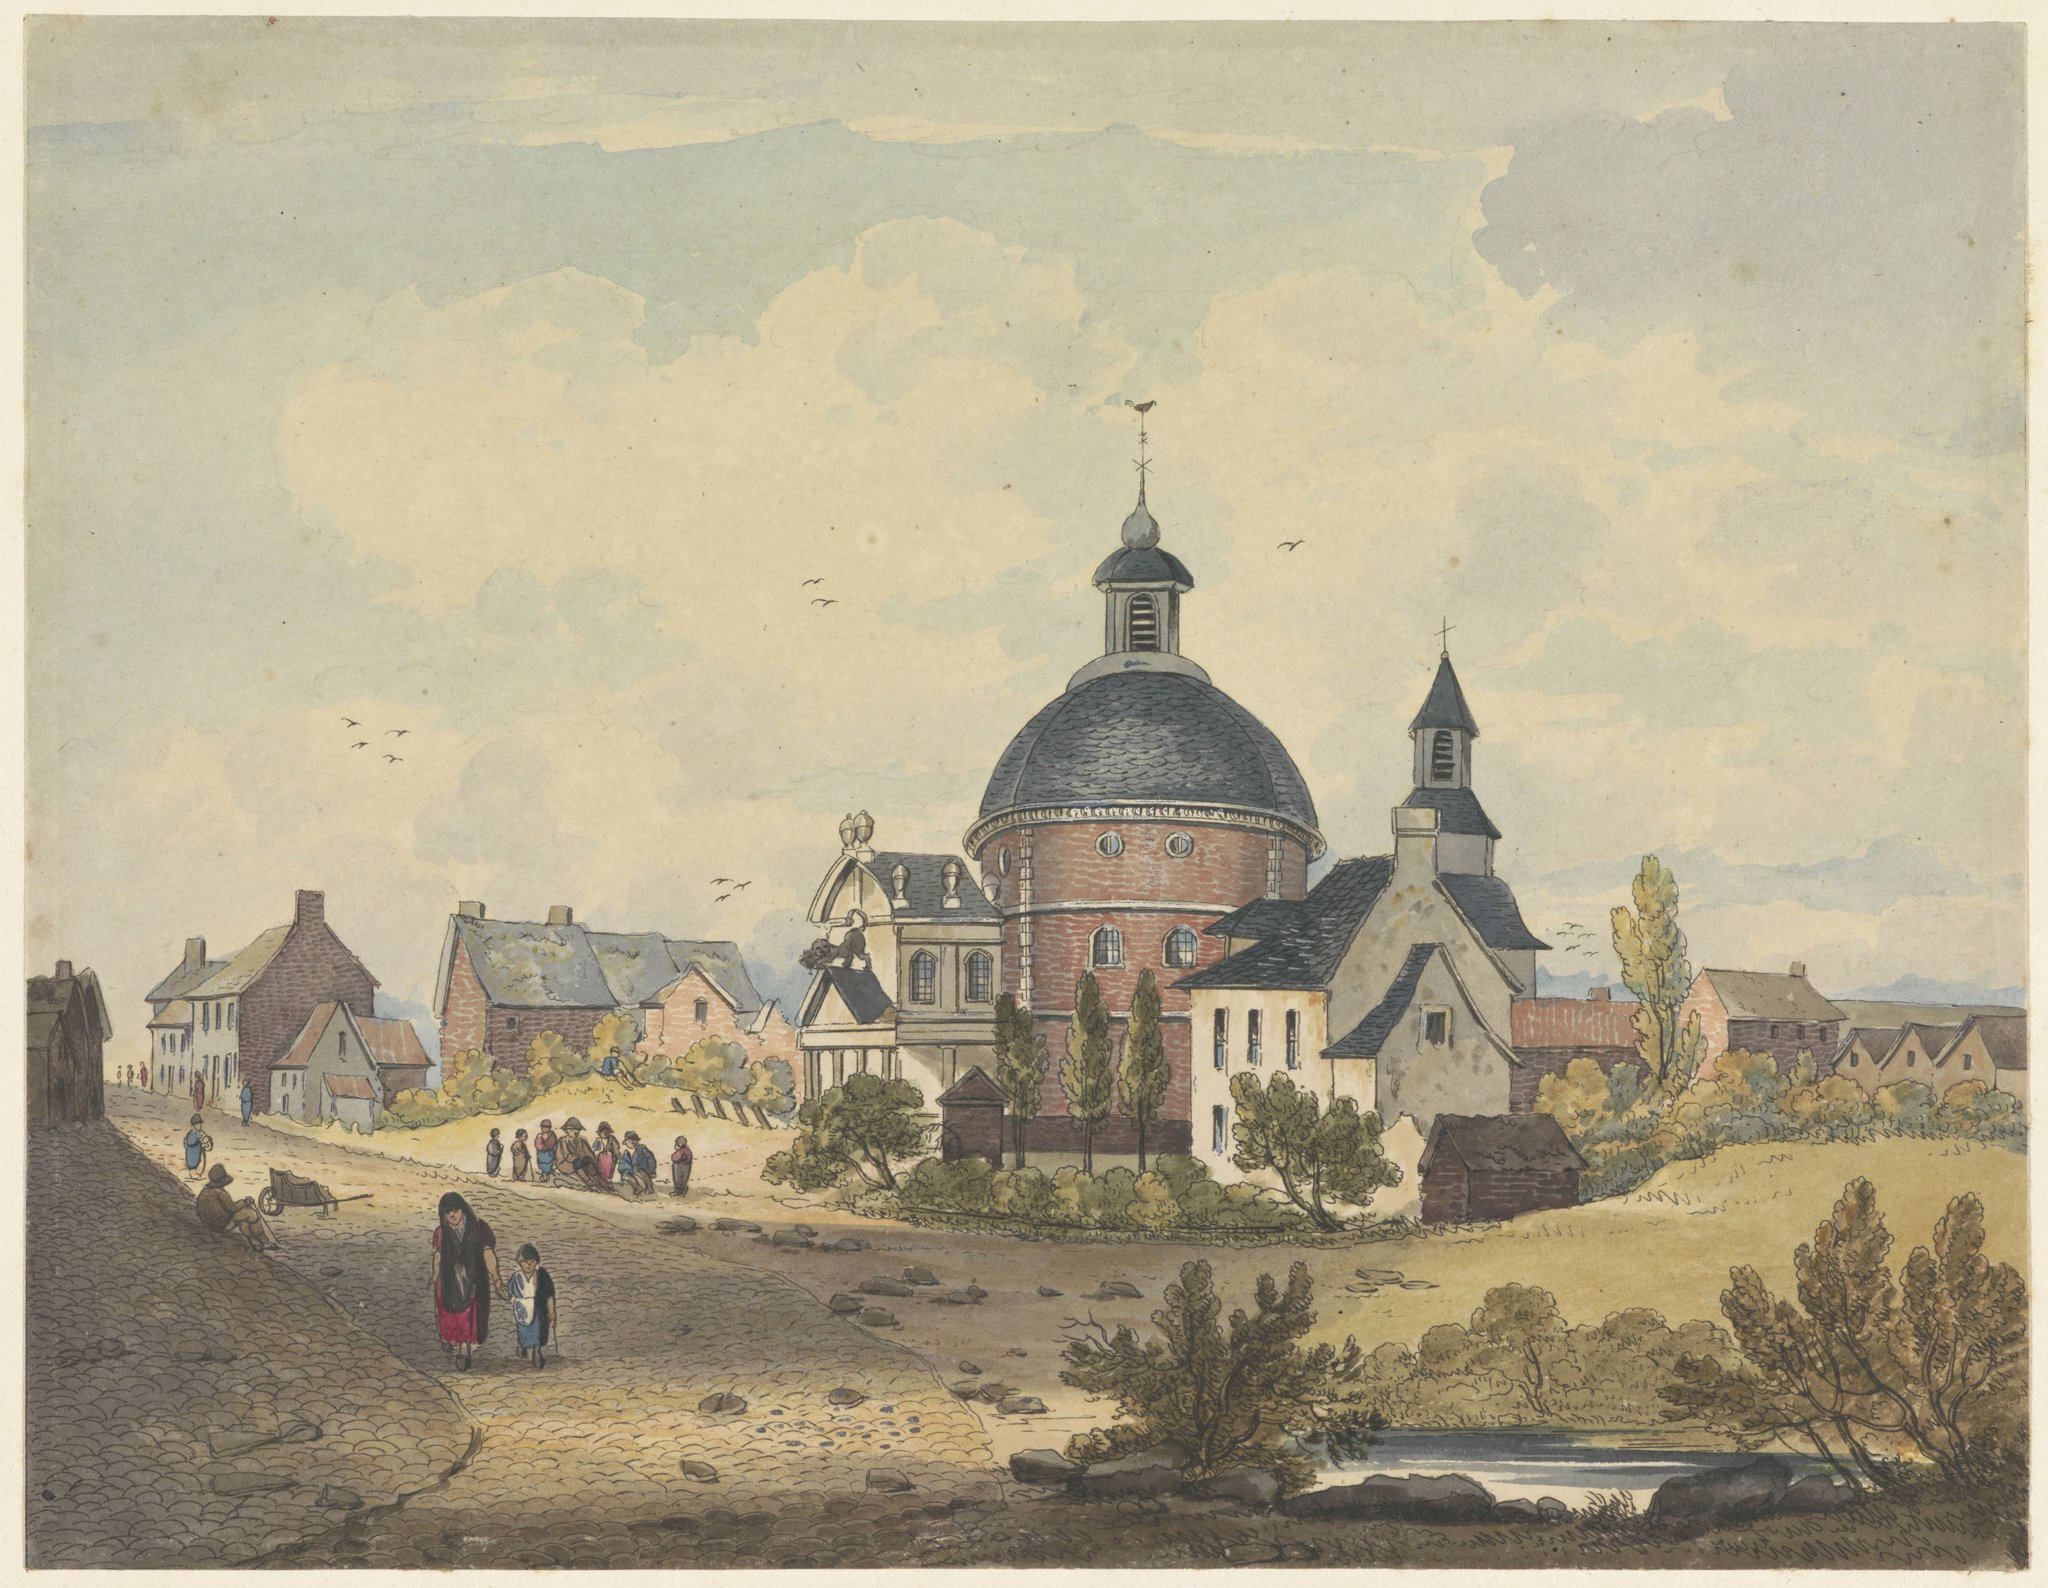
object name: print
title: Zeven platen van Waterloo en omgeving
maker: Anonymous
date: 1815-1825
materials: paper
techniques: etching, hand coloring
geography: low countries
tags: waterloo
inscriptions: collector's mark: Lugt 2228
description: De Sint-Jozefskerk te Waterloo. Onderdeel van een serie van zeven platen met gezichten uit ca. 1820 van de omgeving waar de slag bij Waterloo plaatsvond op 18 juni 1815.